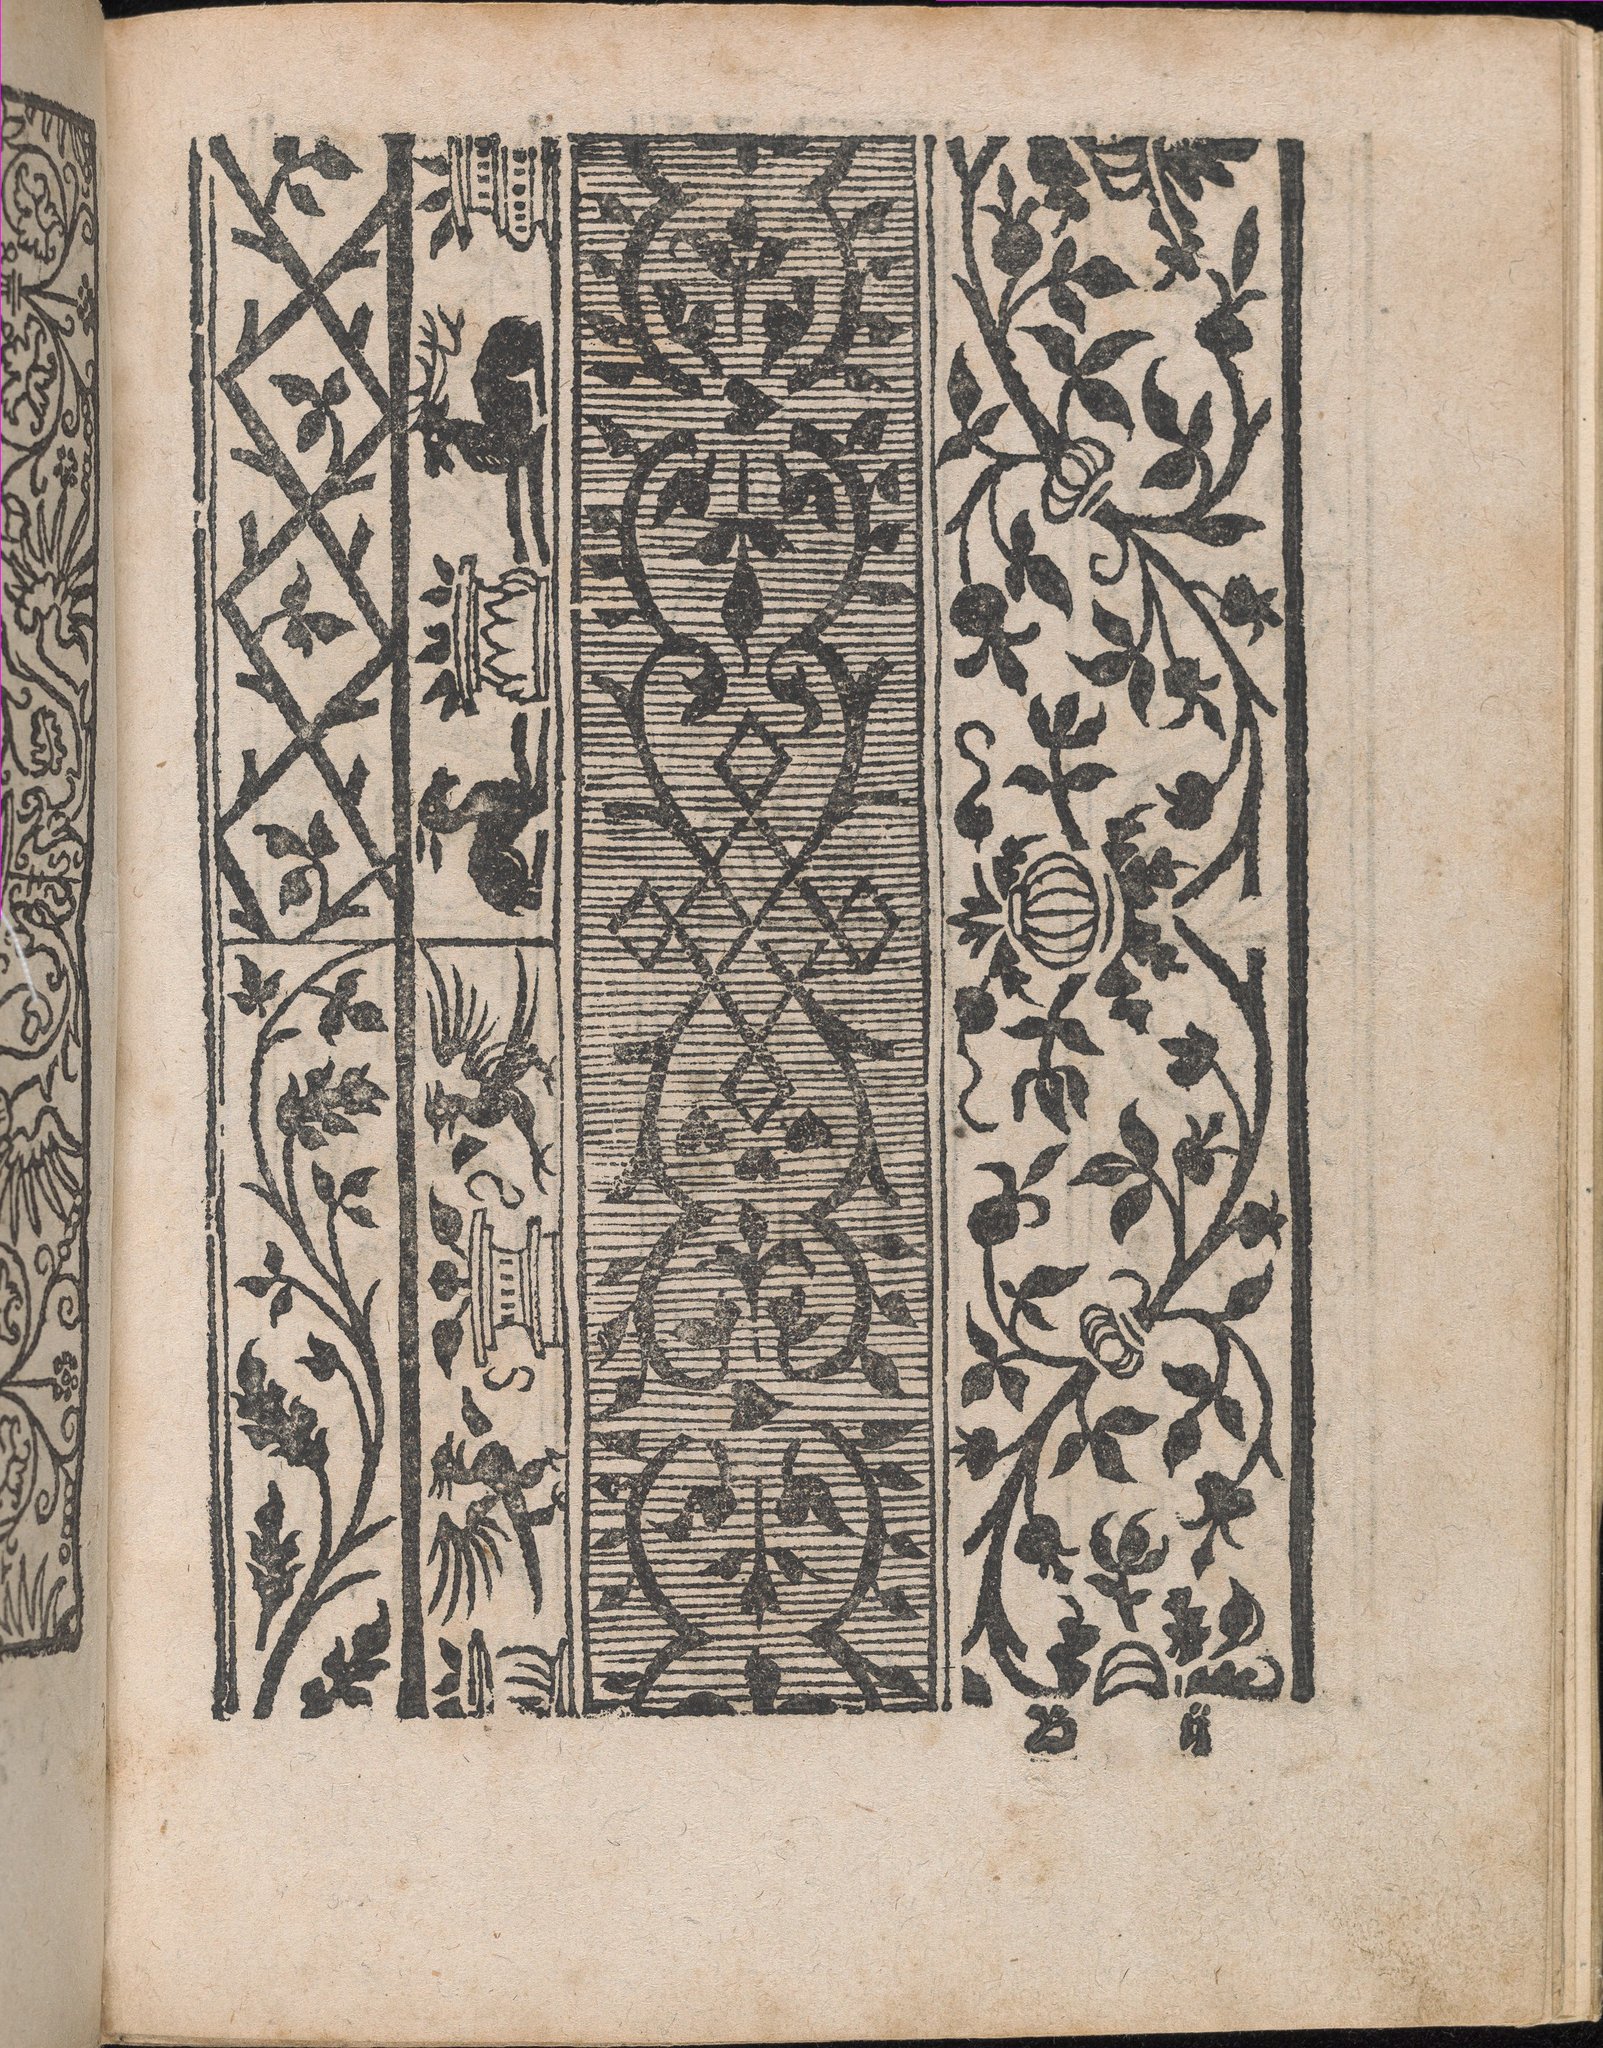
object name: book print ornament architecture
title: Modelbuch aller Art Nehens vn Stickens (Page 6r)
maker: christian egenolff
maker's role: publisher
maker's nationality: german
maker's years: 1502-1555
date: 1535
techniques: woodcut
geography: germany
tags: animals,birds